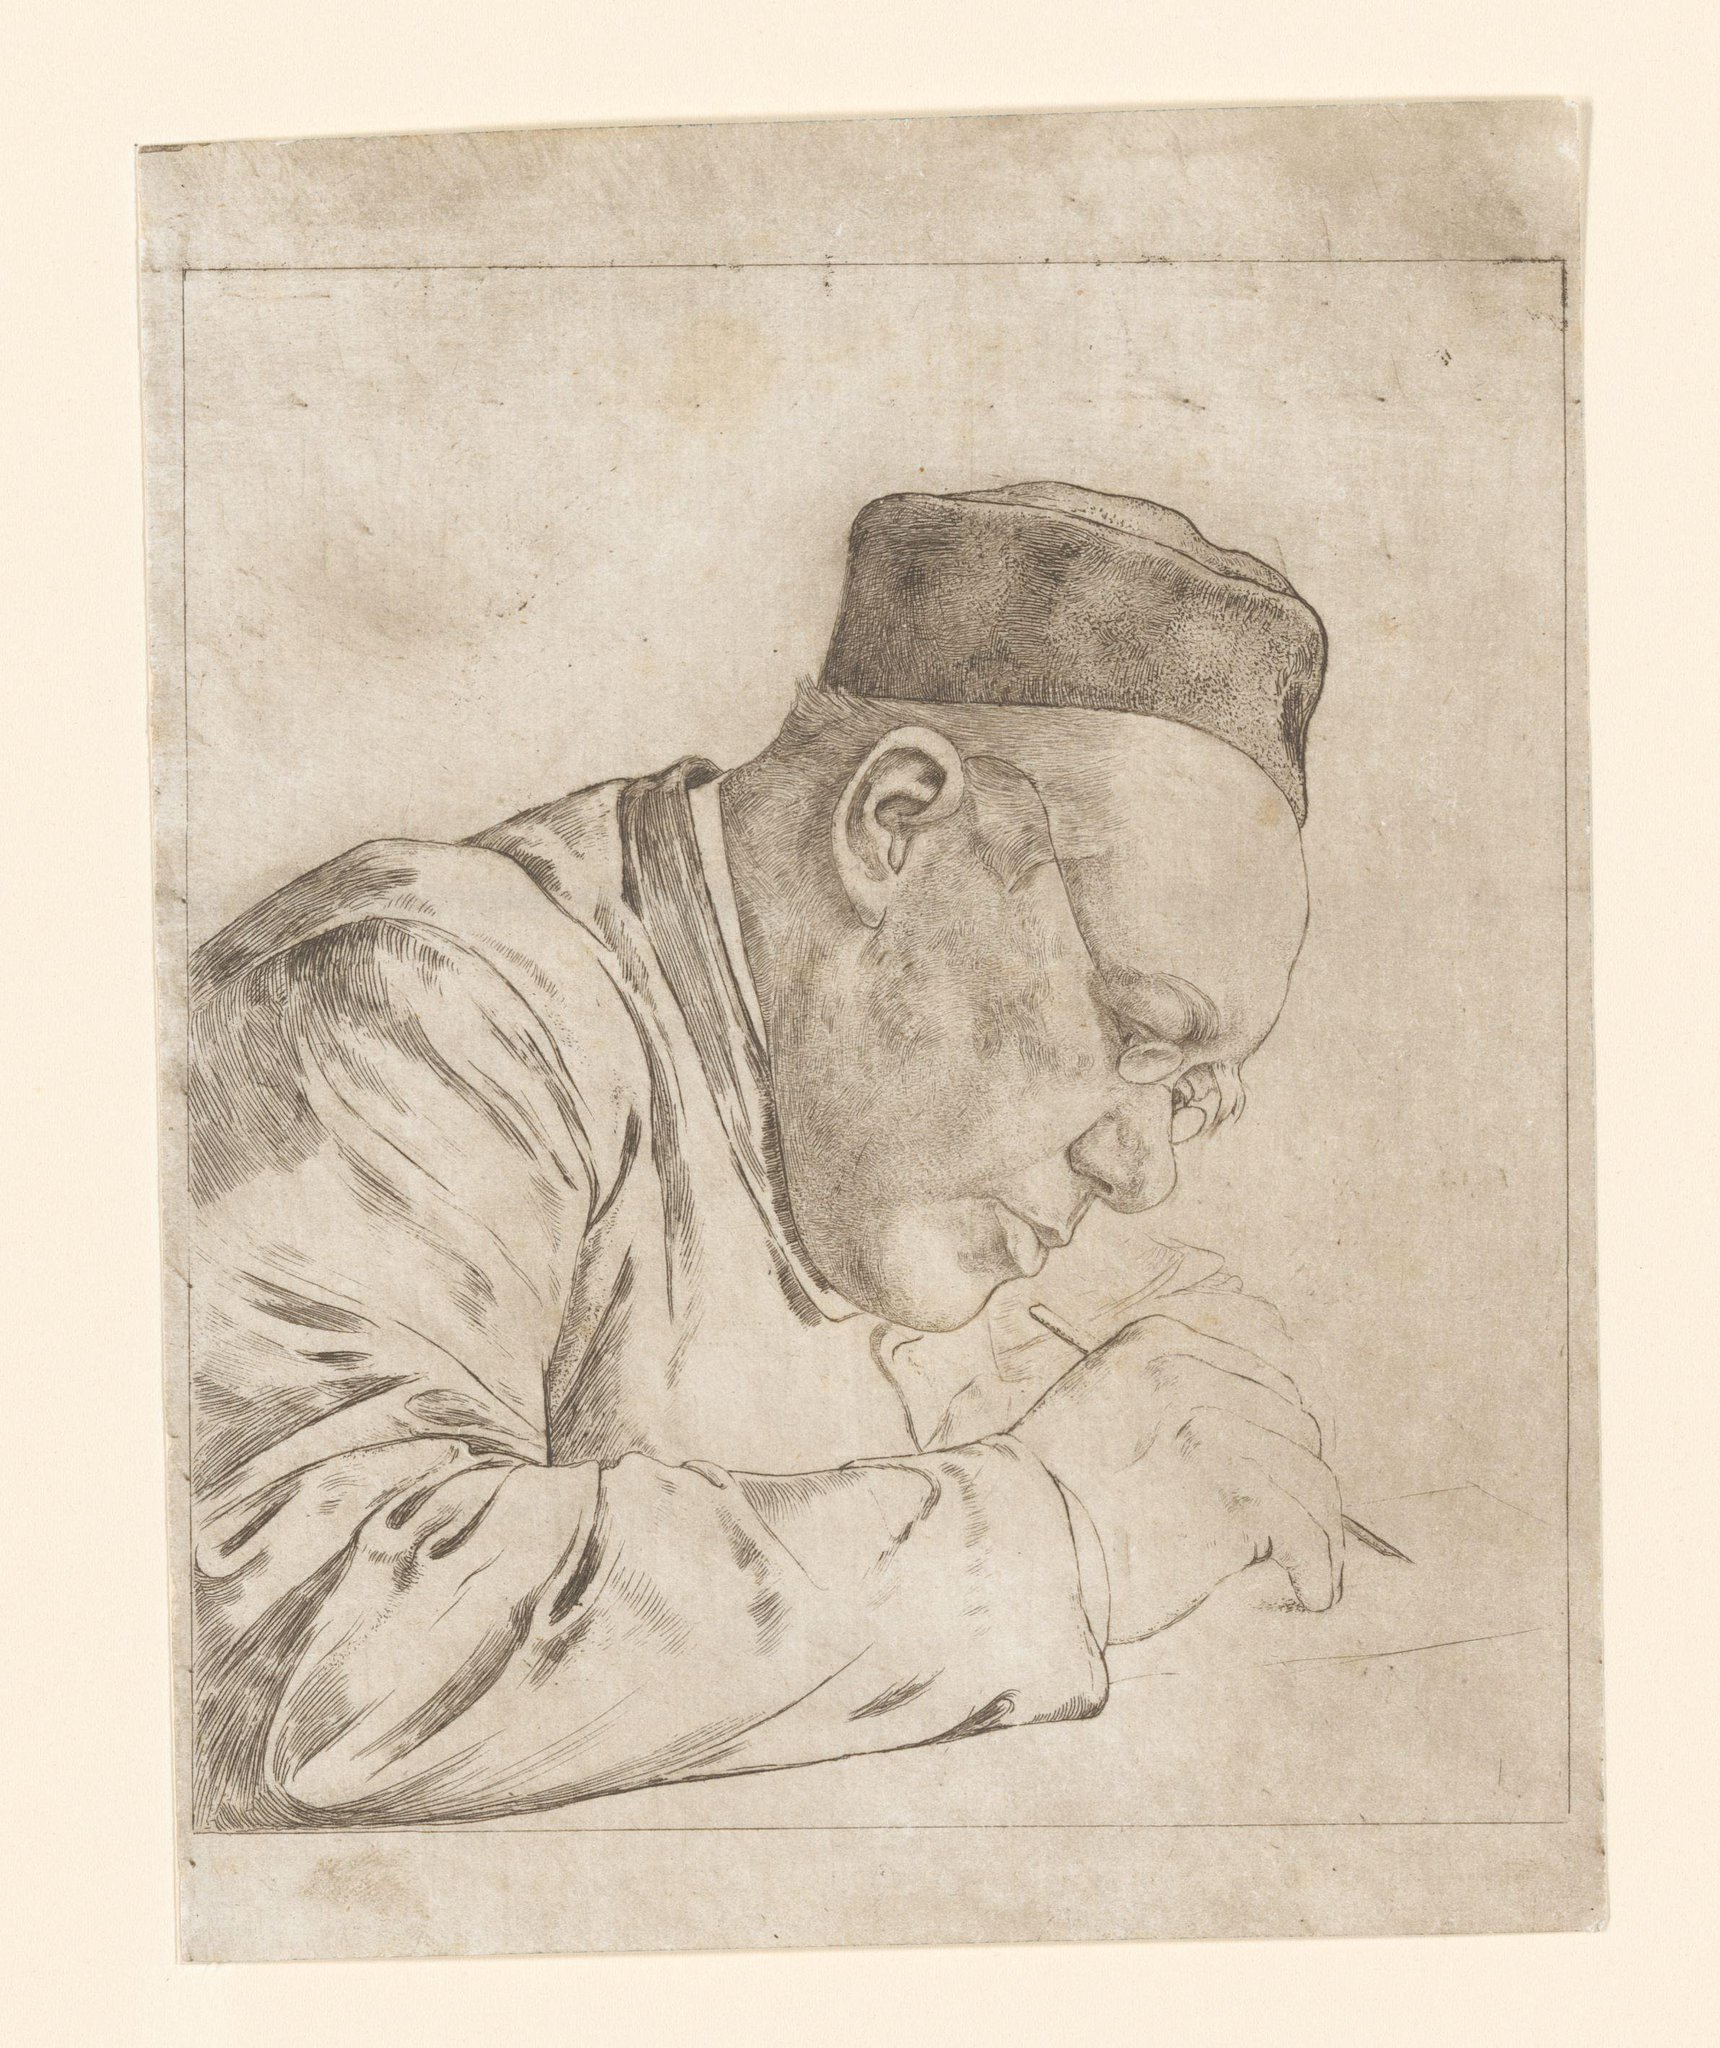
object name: print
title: Portret van Herman Schaepman, schrijvend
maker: jan veth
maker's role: designer, draughtsman, painter, print maker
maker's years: 1864-1925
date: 1892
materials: paper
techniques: etching, intaglio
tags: priest, herman johannes aloysius maria schaepman, historical persons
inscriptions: collector's mark: Lugt 2228